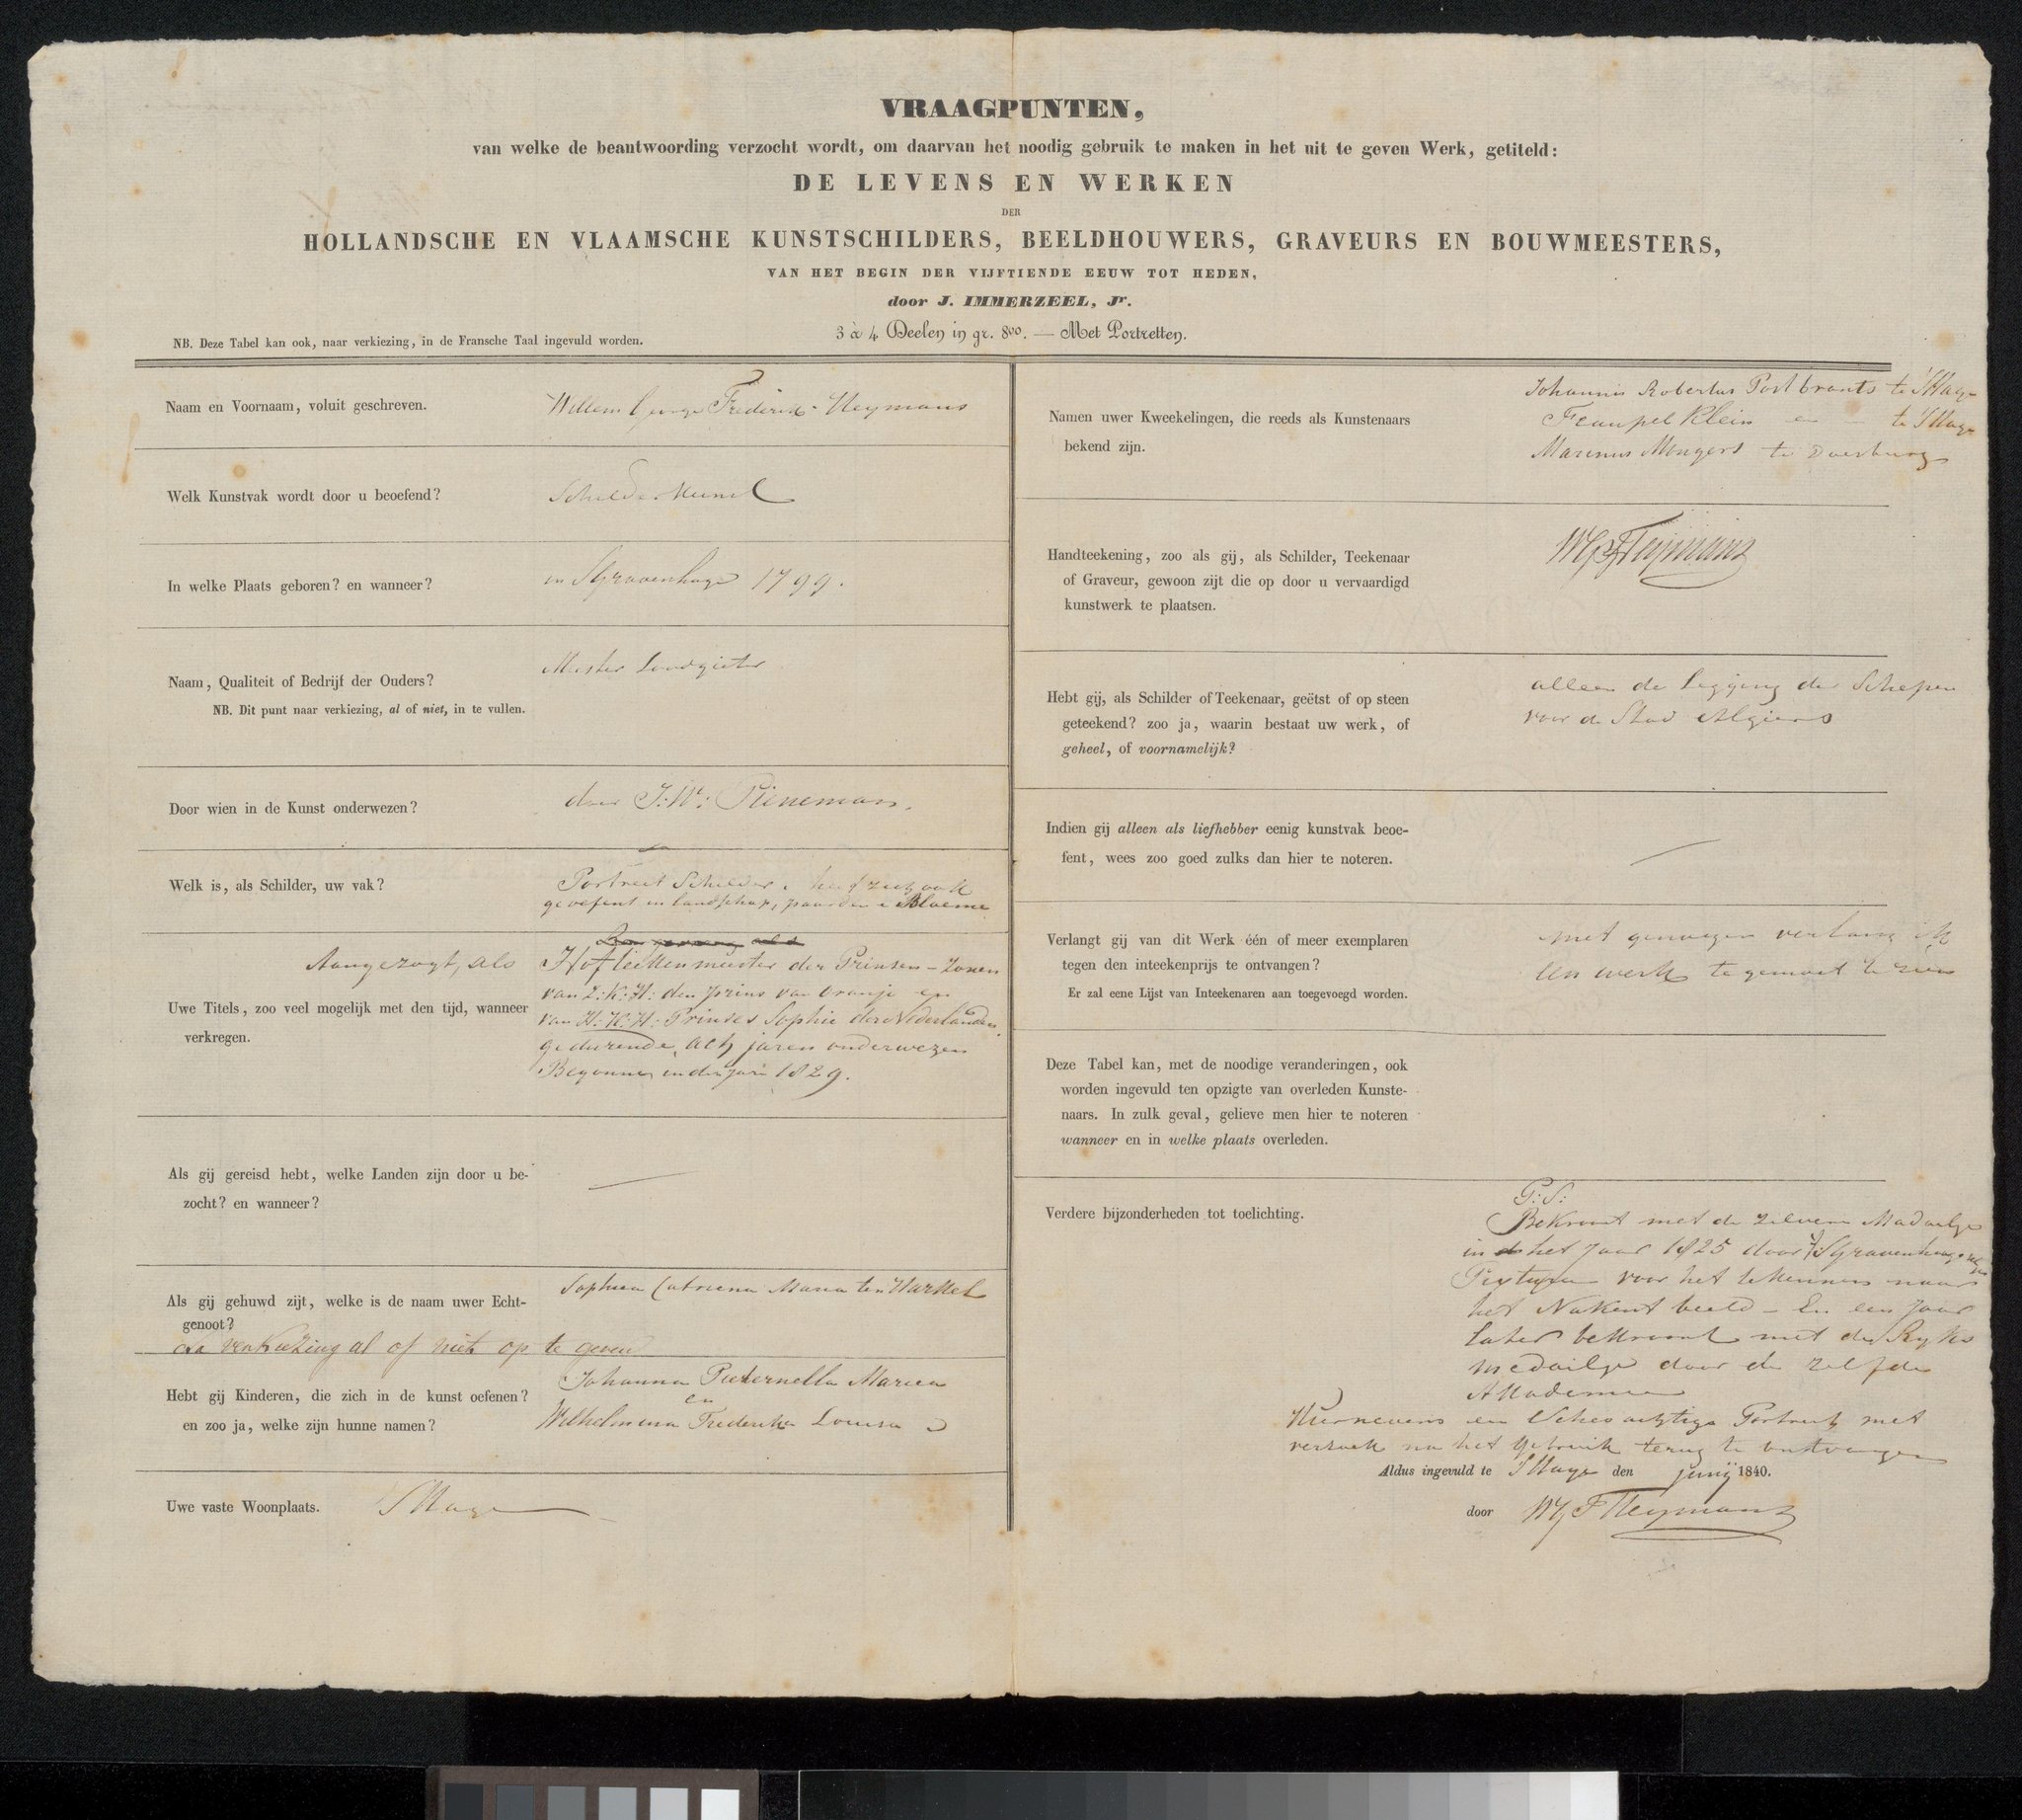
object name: questionnaire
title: Enquêteformulier ingevuld door Willem George Frederik Heijmans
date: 1806-1840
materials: ink, paper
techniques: pen, printing, writing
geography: the hague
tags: draughtsman, willem george frederik heijmans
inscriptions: watermark, inscription: ‘Vraagpunten,/ van welke de beantwoording verzocht wordt, om daarvan het noodig gebruik te maken in het uit te geven Werk, getiteld: De levens en werken/ der Hollandsche en Vlaamsche kunstschilders, beeldhouwers,/ graveurs en bouwmeesters, van het begin der vijftiende eeuw tot heden/ door J. Immerzeel, Jr.’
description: Opgenomen in: Immerzeel, J. Jr., De levens en werken der Hollandsche en Vlaamsche kunstschilders, beeldhouwers, graveurs en bouwmeesters, van het begin der vijftiende eeuw tot heden, Amsterdam: J.C. van Kesteren, 1842-1843.